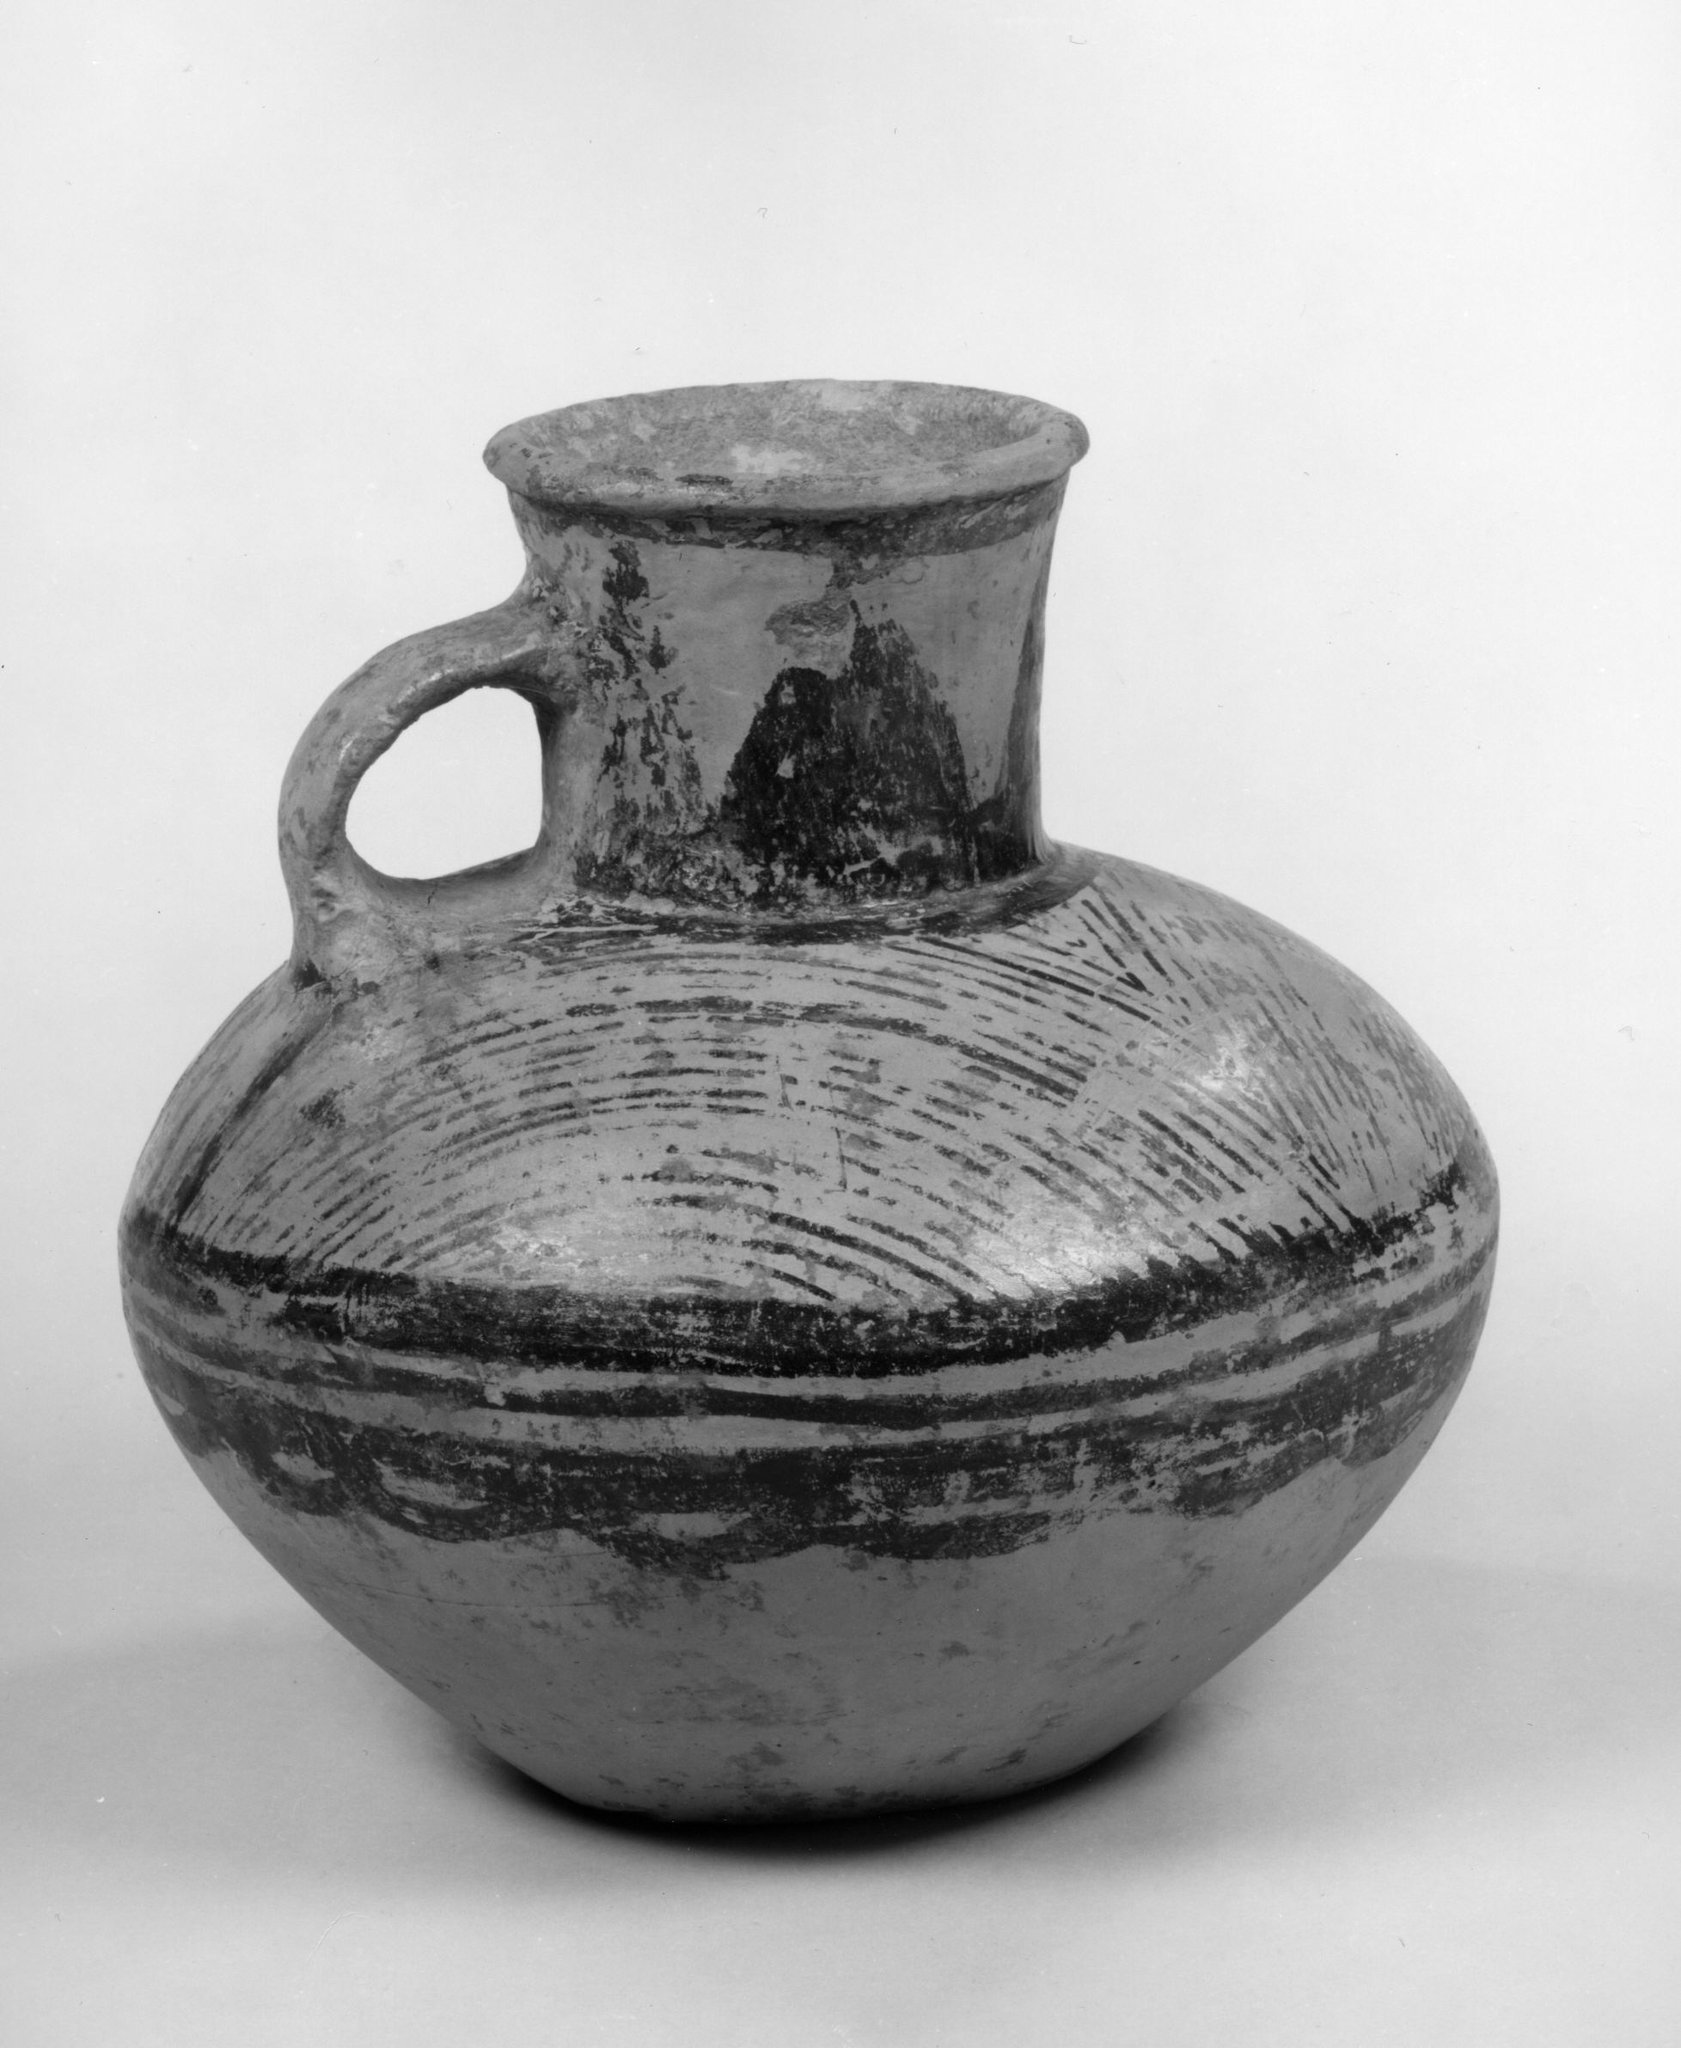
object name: jug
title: Jug (Hu)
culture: chinese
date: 2500-2300 BCE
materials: earthenware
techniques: painting